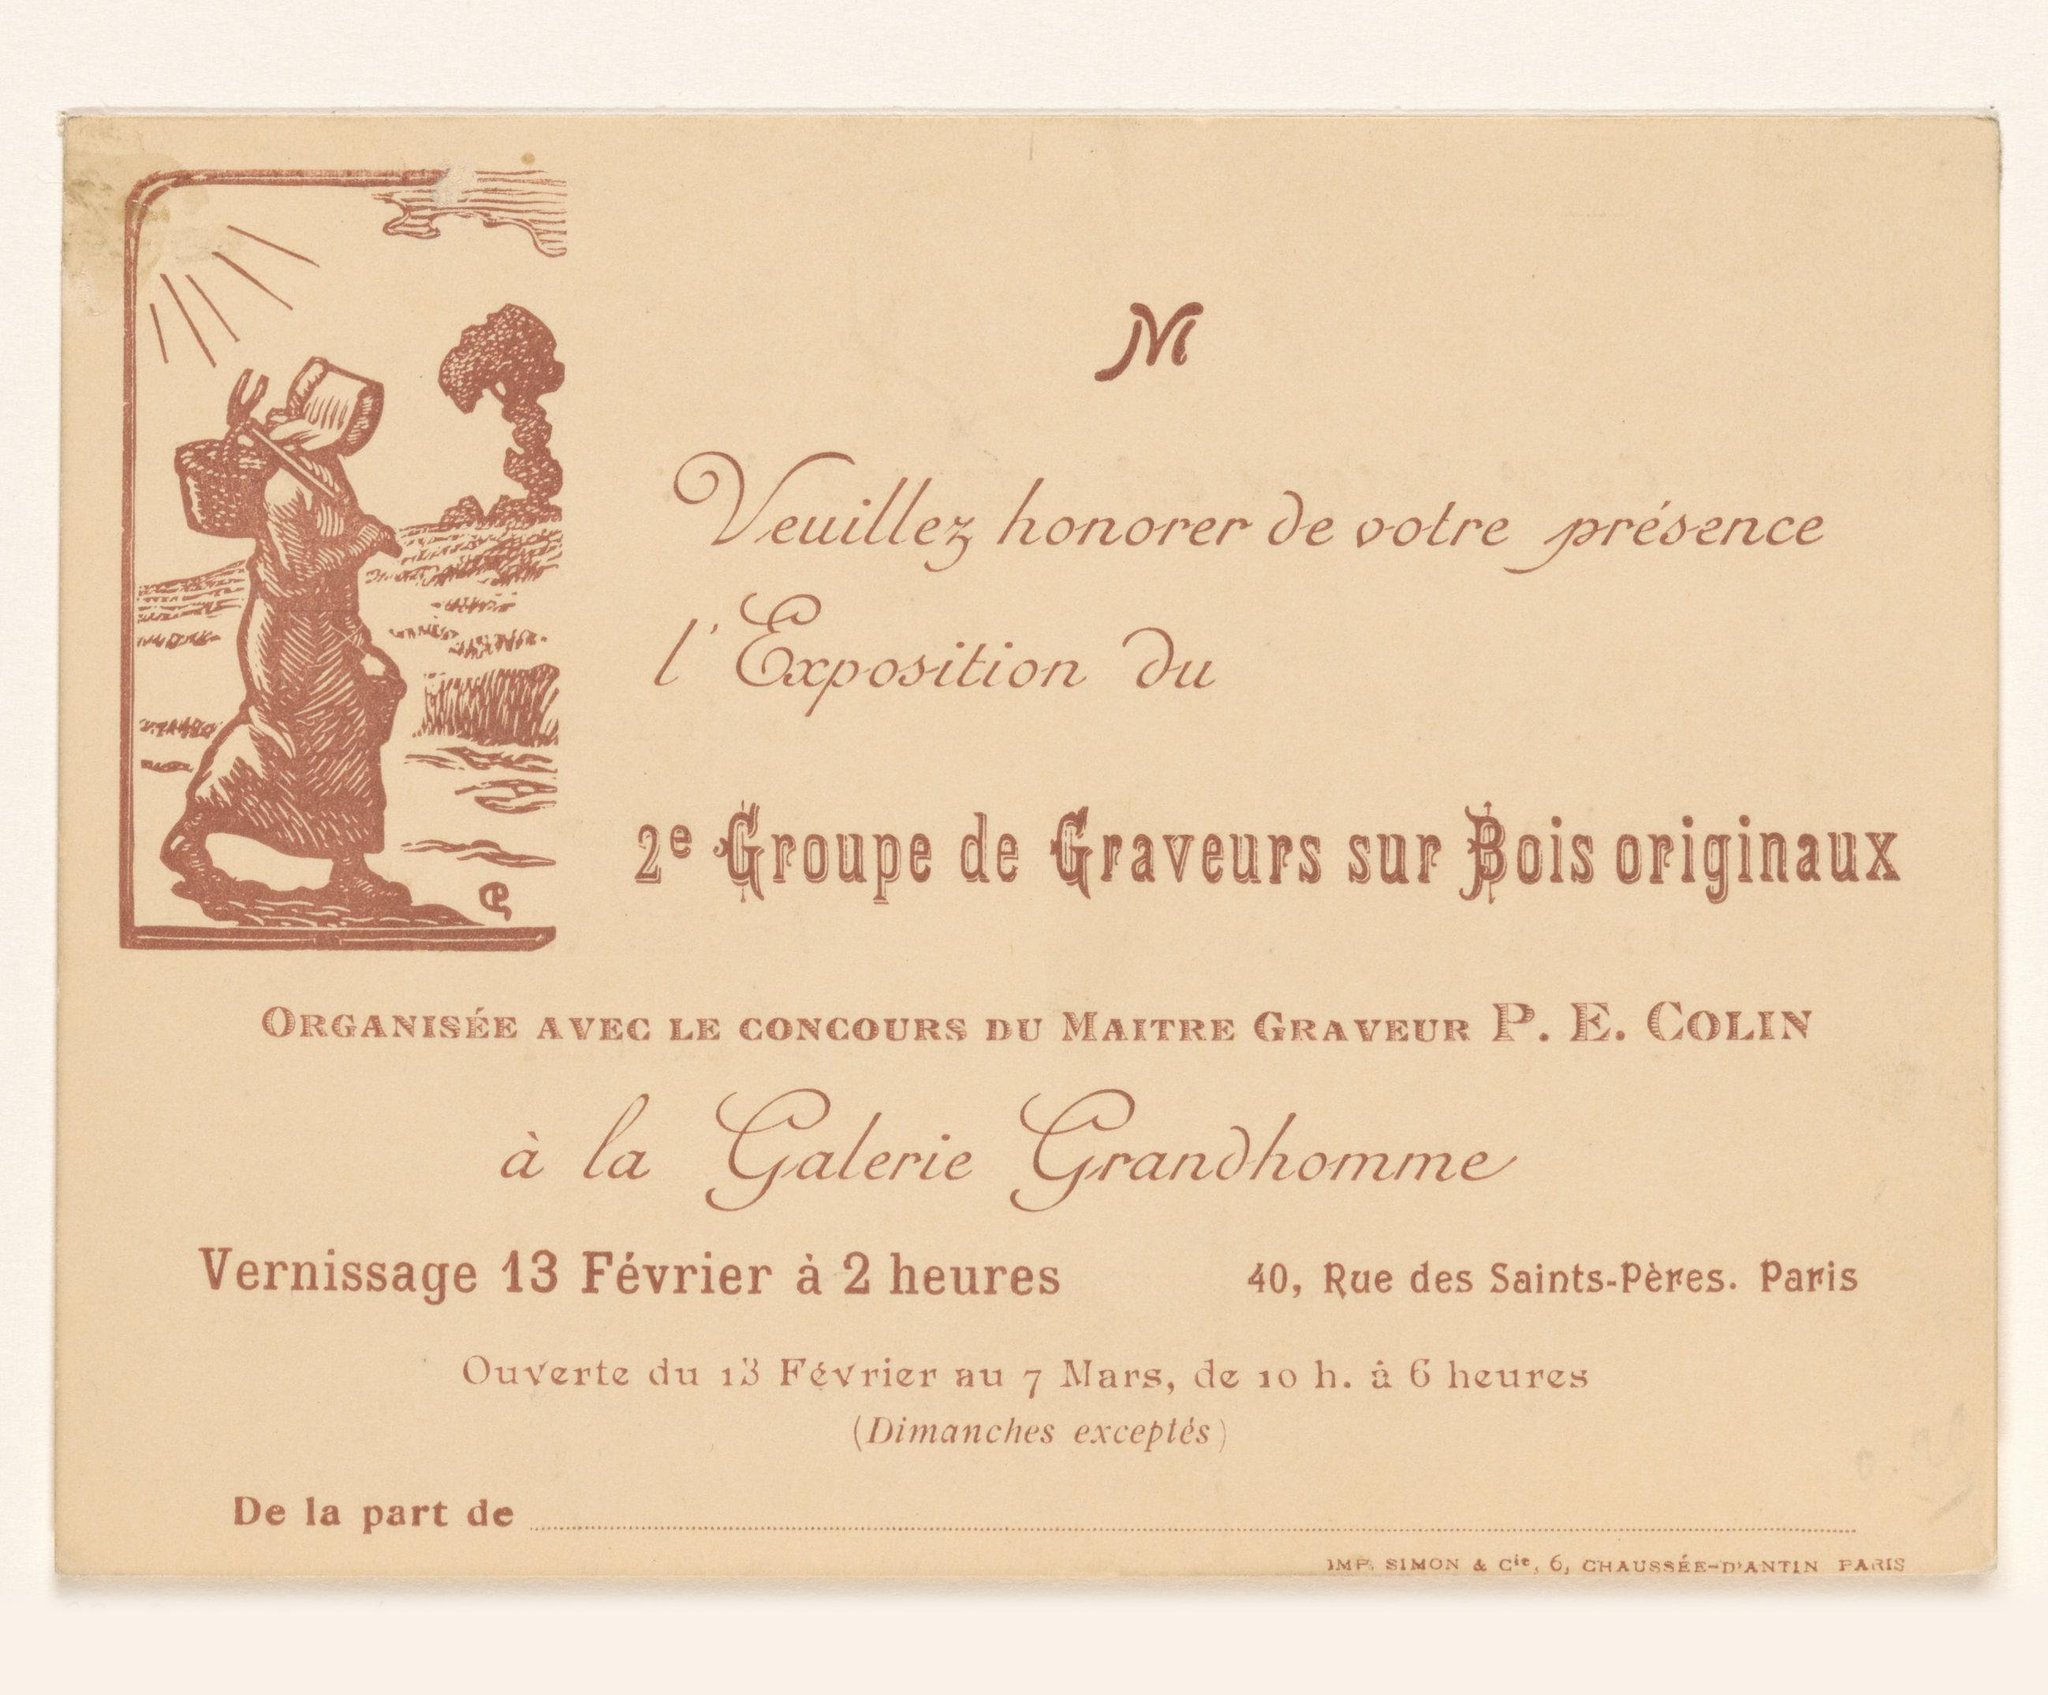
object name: invitation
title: Uitnodiging voor een expositie in Galerie Grandhomme te Parijs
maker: paul-emile colin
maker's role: print maker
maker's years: 1867-1949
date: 1914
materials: paper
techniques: lithograph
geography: paris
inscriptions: collector's mark: Lugt 2228, collector's mark: Lugt 4780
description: Op verso zijn de namen van de deelnemende kunstenaars vermeld.